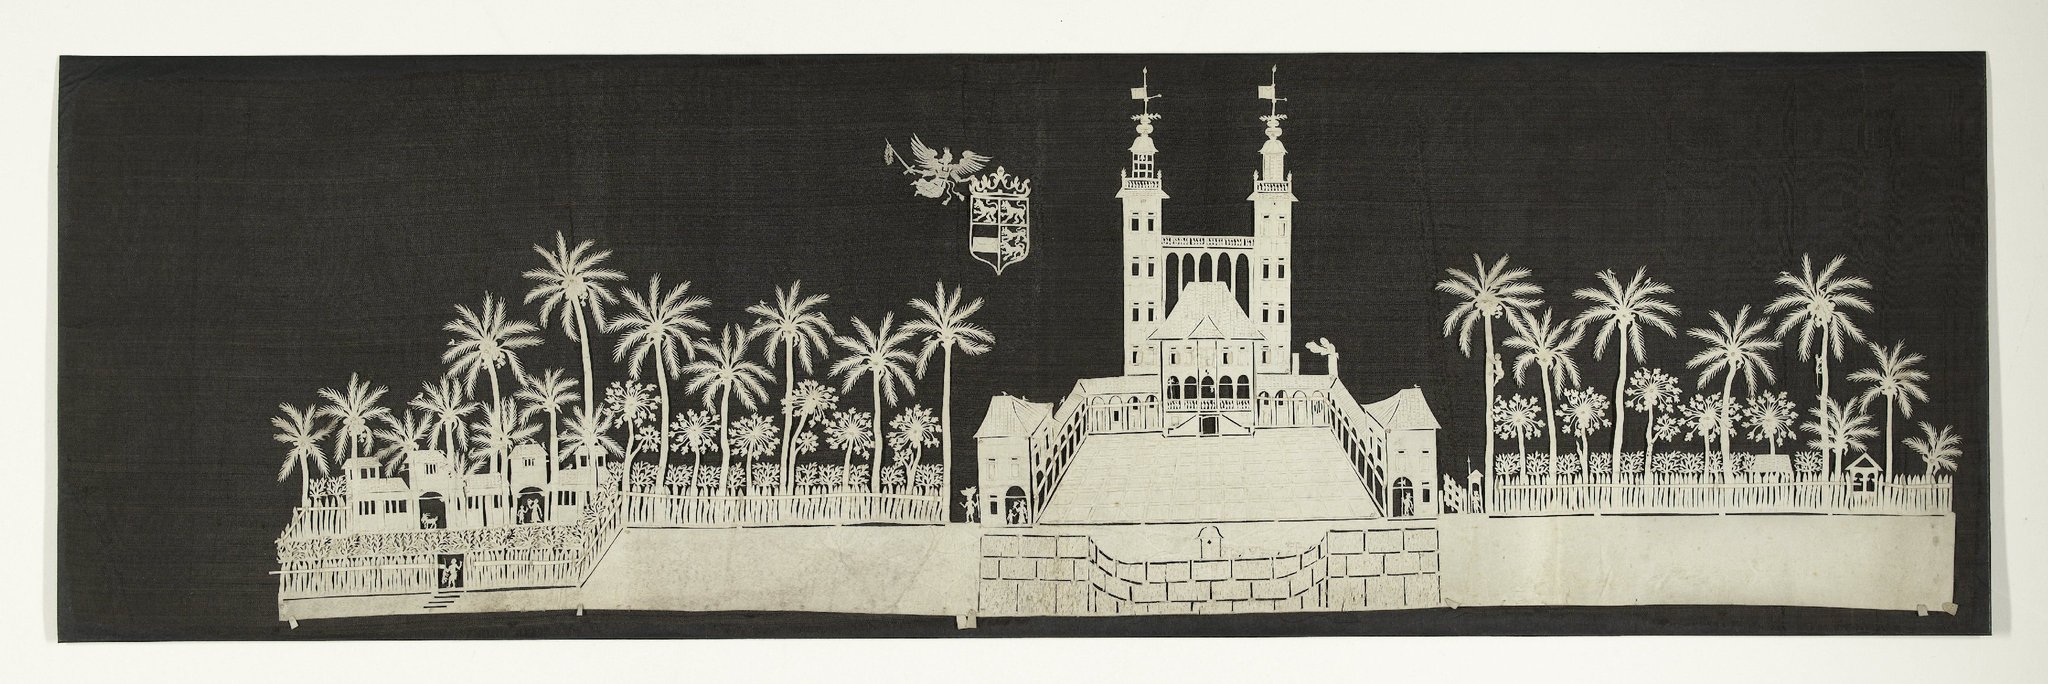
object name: cut paper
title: Vrijburg Palace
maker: Anonymous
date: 1642-1652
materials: paper, parchment, silk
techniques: cutting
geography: brazil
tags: earl, johan maurits graaf van nassau-siegen, slavery; serfs and enslaved persons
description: Johan Maurits only stayed in Brazil for seven years. His many costly plans for the colony suggest that the governor himself had envisioned this differently. Construction of his Vrijburg Palace was never completed, but this cut parchment silhouette gives an impression of the palace with an observatory in one of the towers. There are slave quarters on both sides.